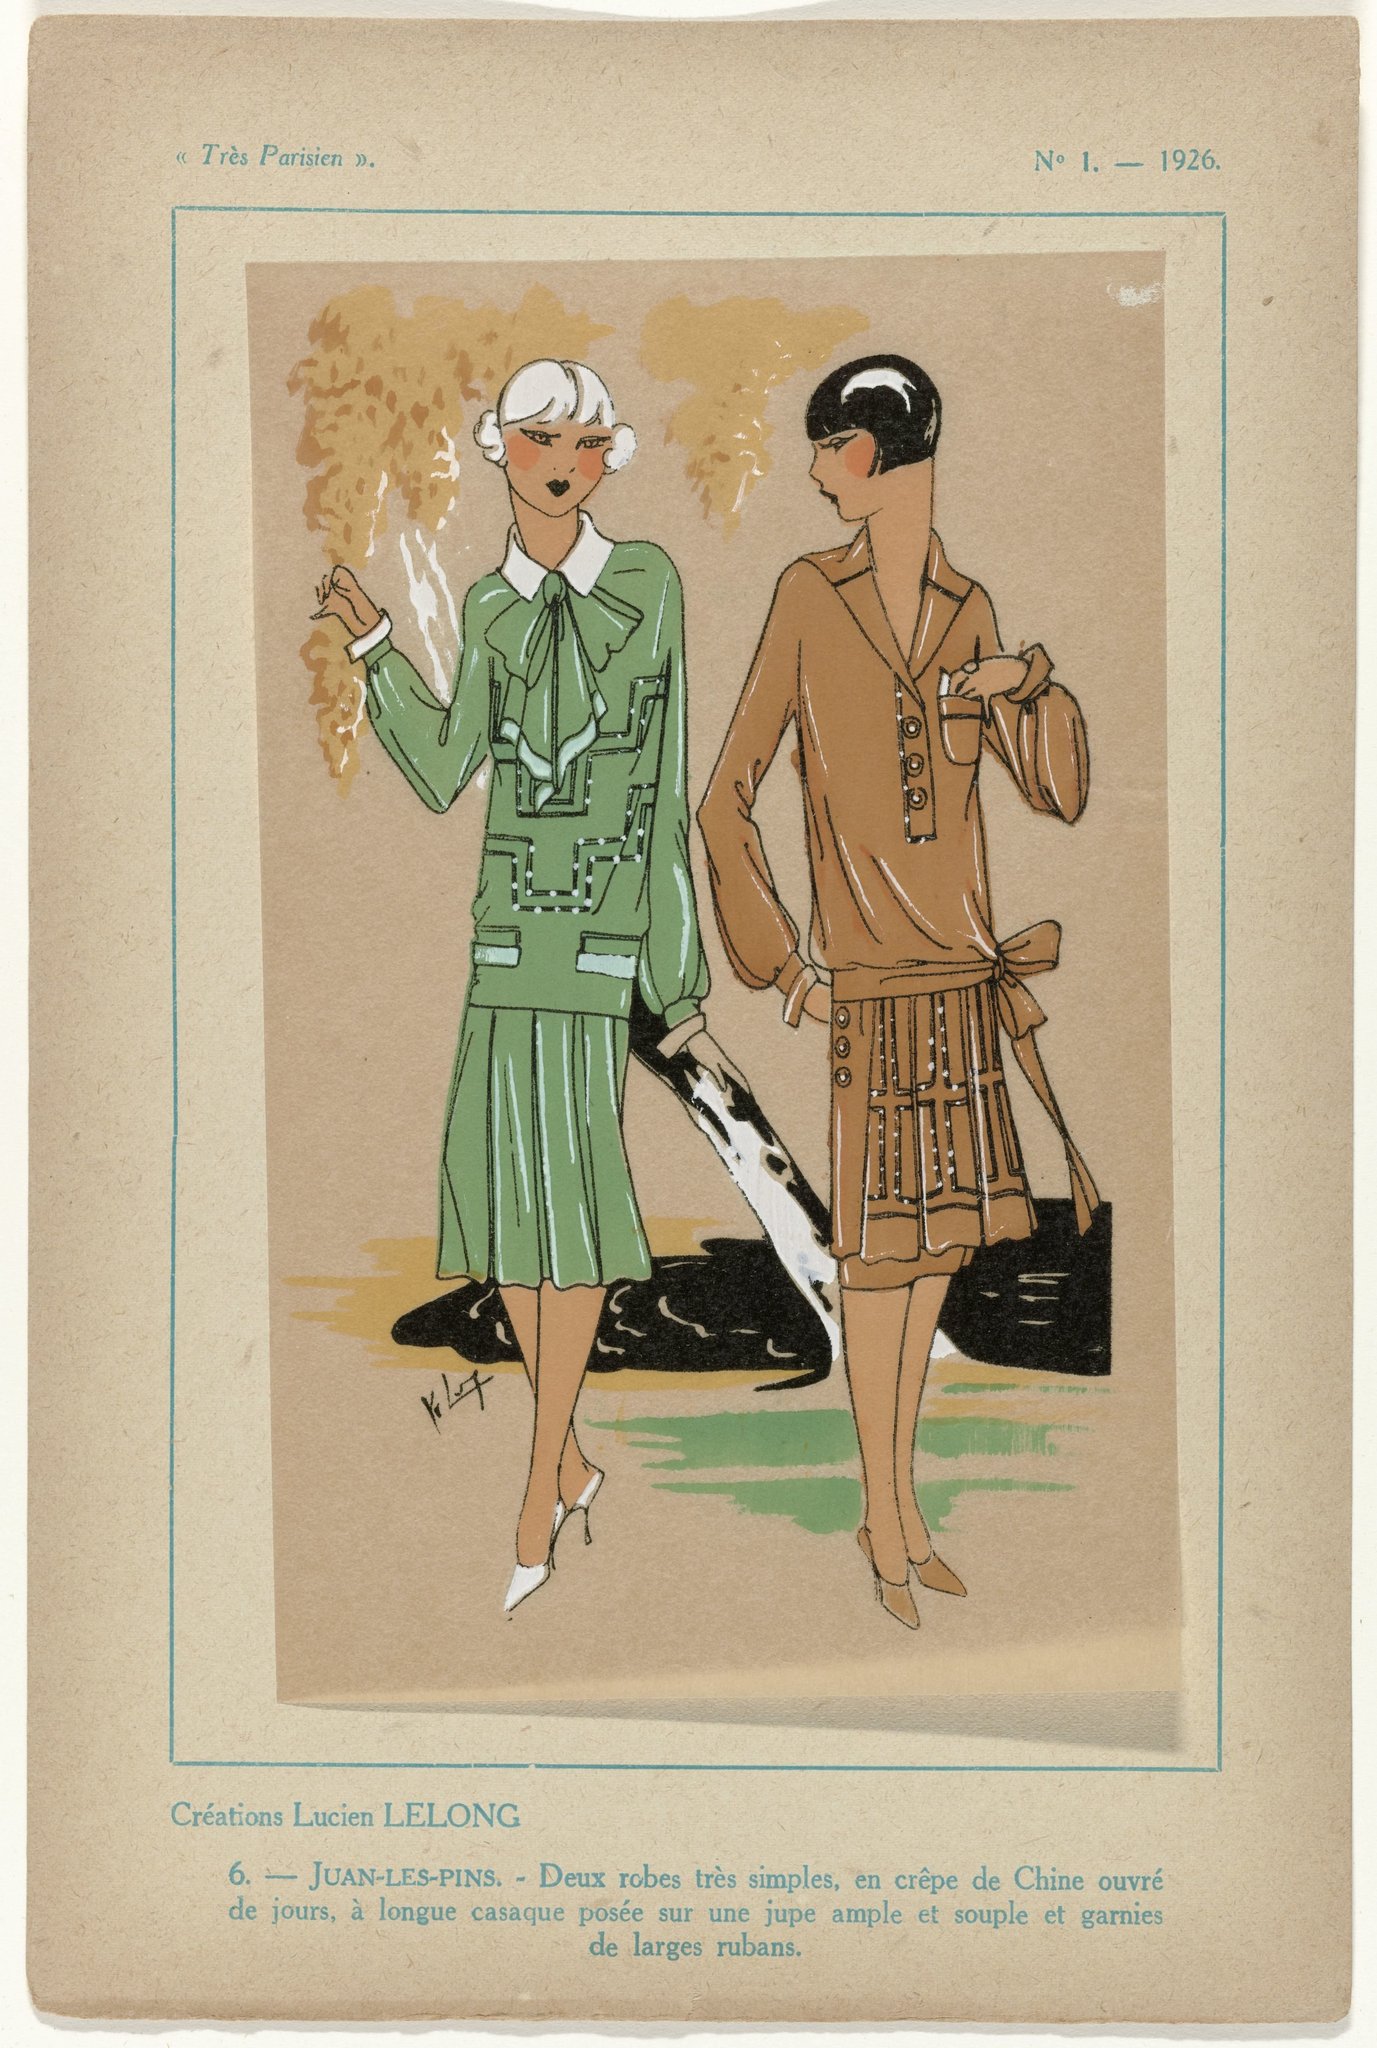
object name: fashion print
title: Très Parisien, 1926, No. 1, Pl. 6: Créations Lucien LELONG - JUAN-LES-PINS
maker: g-p. joumard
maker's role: publisher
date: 1926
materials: paper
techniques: hand coloring, letterpress printing, lithography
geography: paris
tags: dress, gown: day dress (+ women's clothes), fashion plates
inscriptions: caption: ‘6.- JUAN-LES-PINS. - deux robes très simples de crêpe de chine ouvré de jours, à longue casaque posé sur une jupe ample et souple et garnies de larges rubans’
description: Twee eenvoudige japonnen van Crêpe de Chine van Lucien Lelong, net over de knie vallend. Prent uit het modetijdschrift Très Parisien...La Mode, Le Chic, L'Élégance (1920-1936)